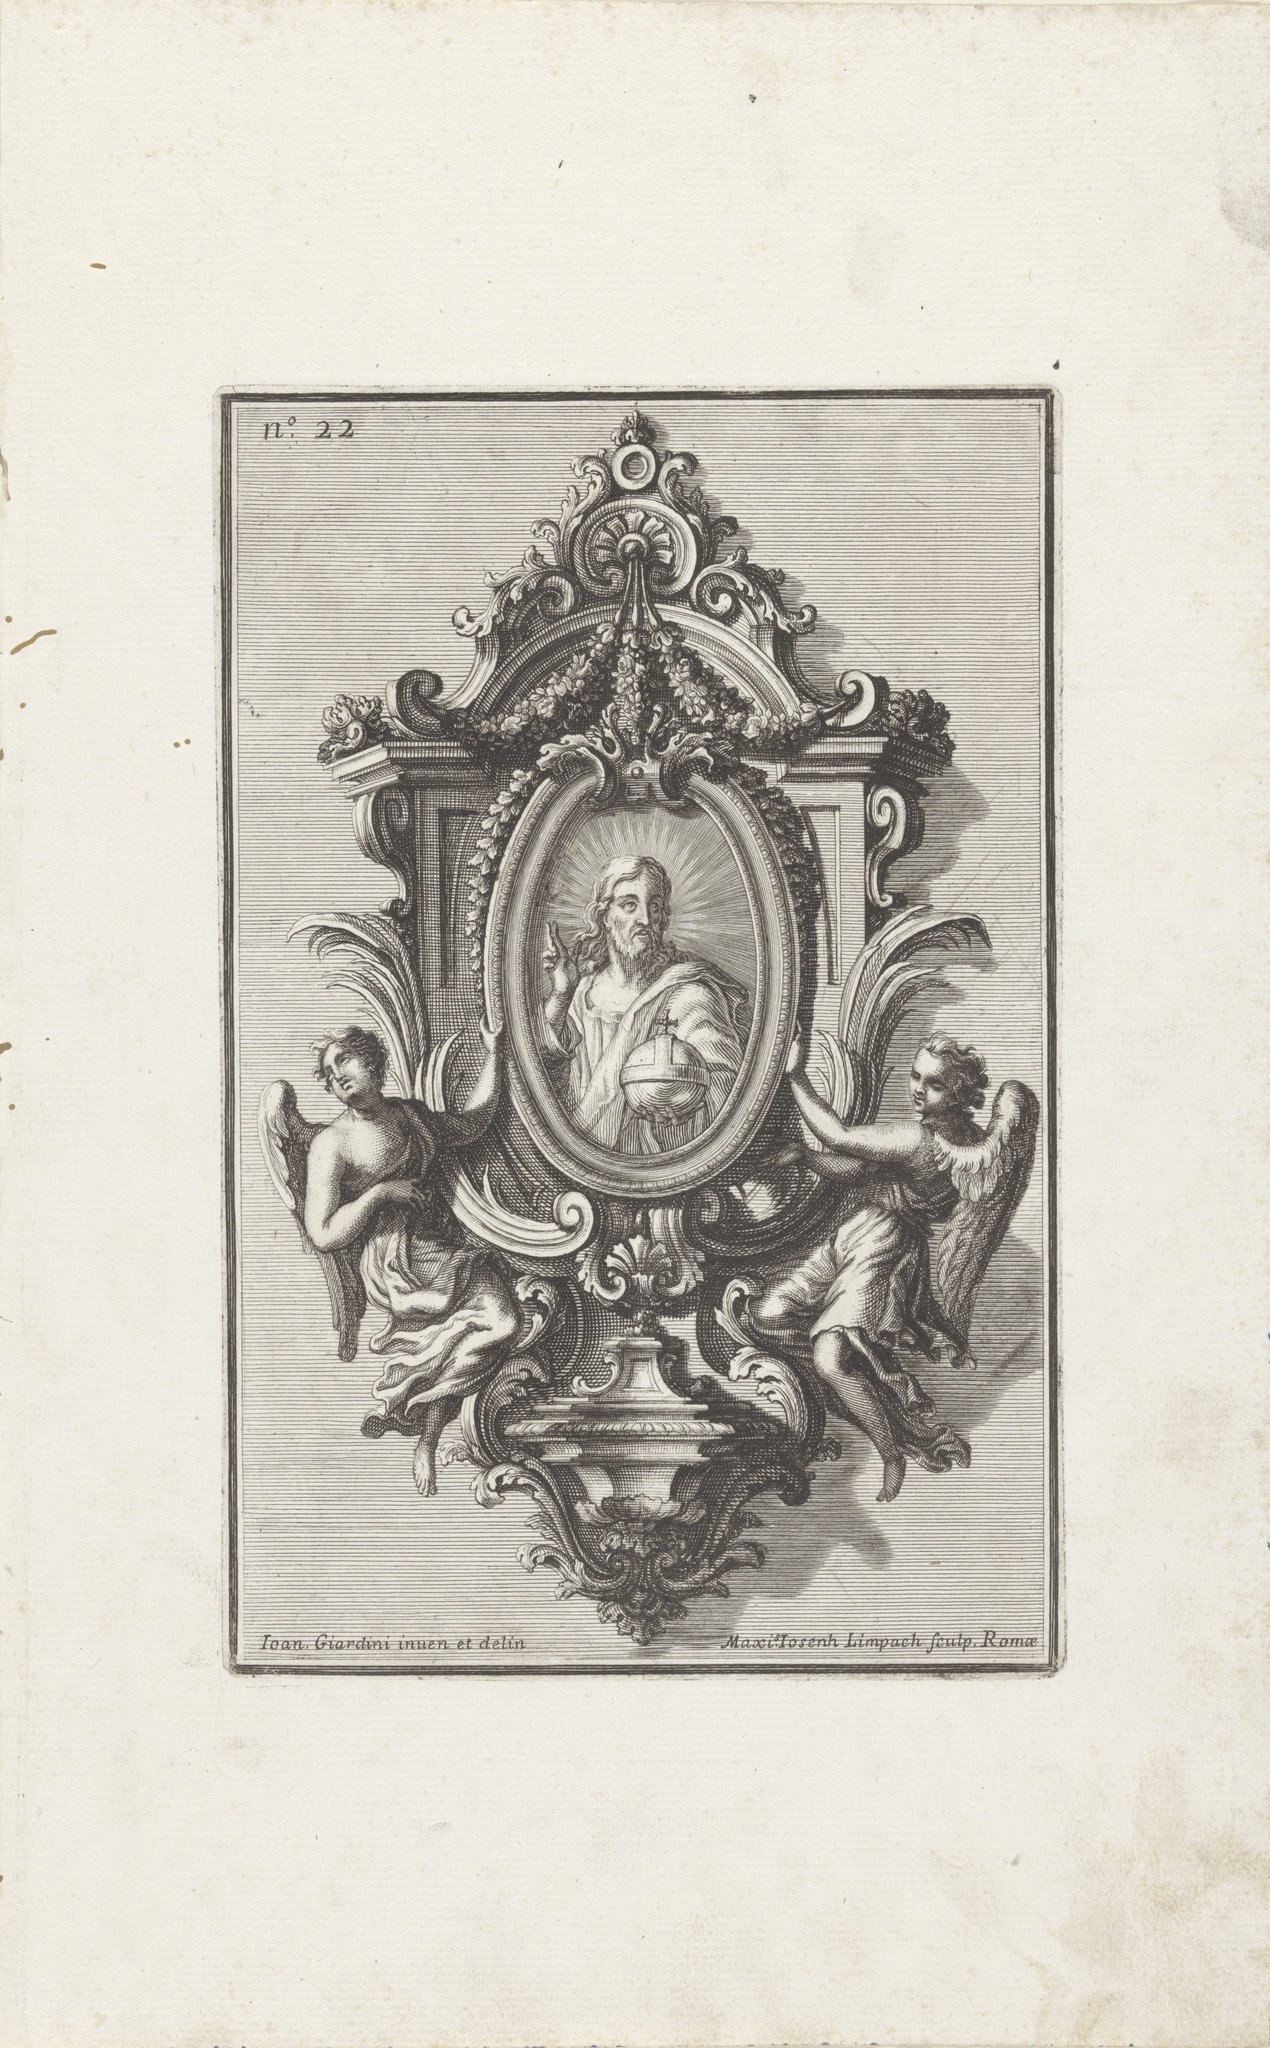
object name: print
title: Diverse kerkelijke voorwerpen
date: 1714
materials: paper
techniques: etching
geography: vatican city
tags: ornaments ~ art, 'salvator mundi', making a blessing gesture; an orb in his hand or at his feet, angels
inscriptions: collector's mark: Lugt 2228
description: Prent maakt deel uit van een reeks van 100 ornamentprenten naar ontwerp van Giovanni Giardini.